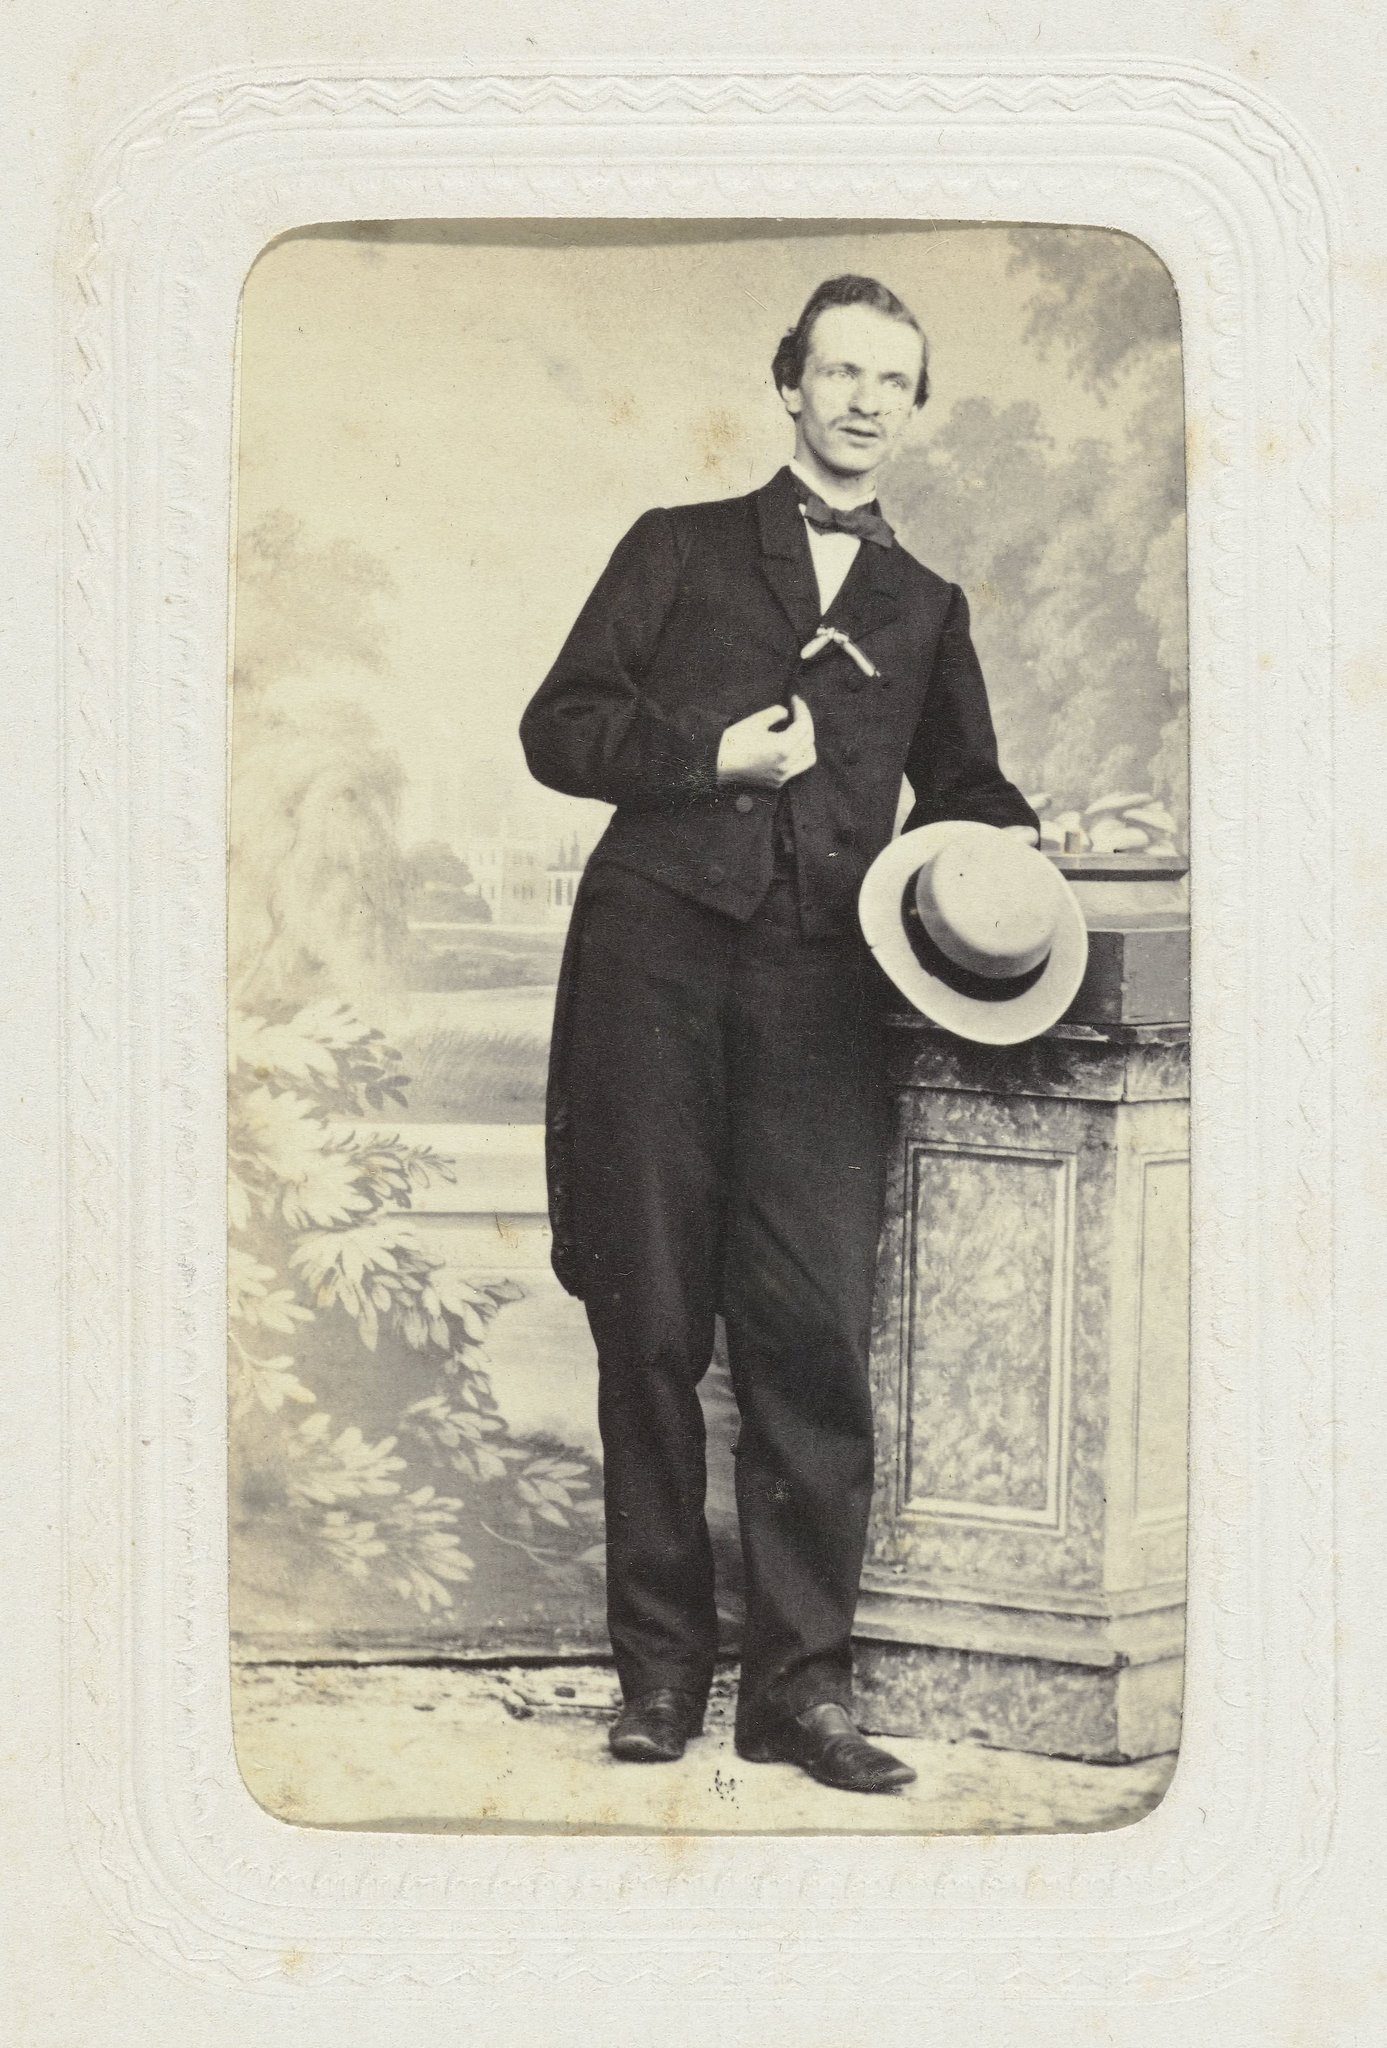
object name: carte de visite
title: Studioportret van een man leunend tegen een pilaar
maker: Anonymous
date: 1863-1866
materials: cardboard, paper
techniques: albumen print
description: De man draagt een zwart kostuum en heeft een rieten hoed in zijn hand.